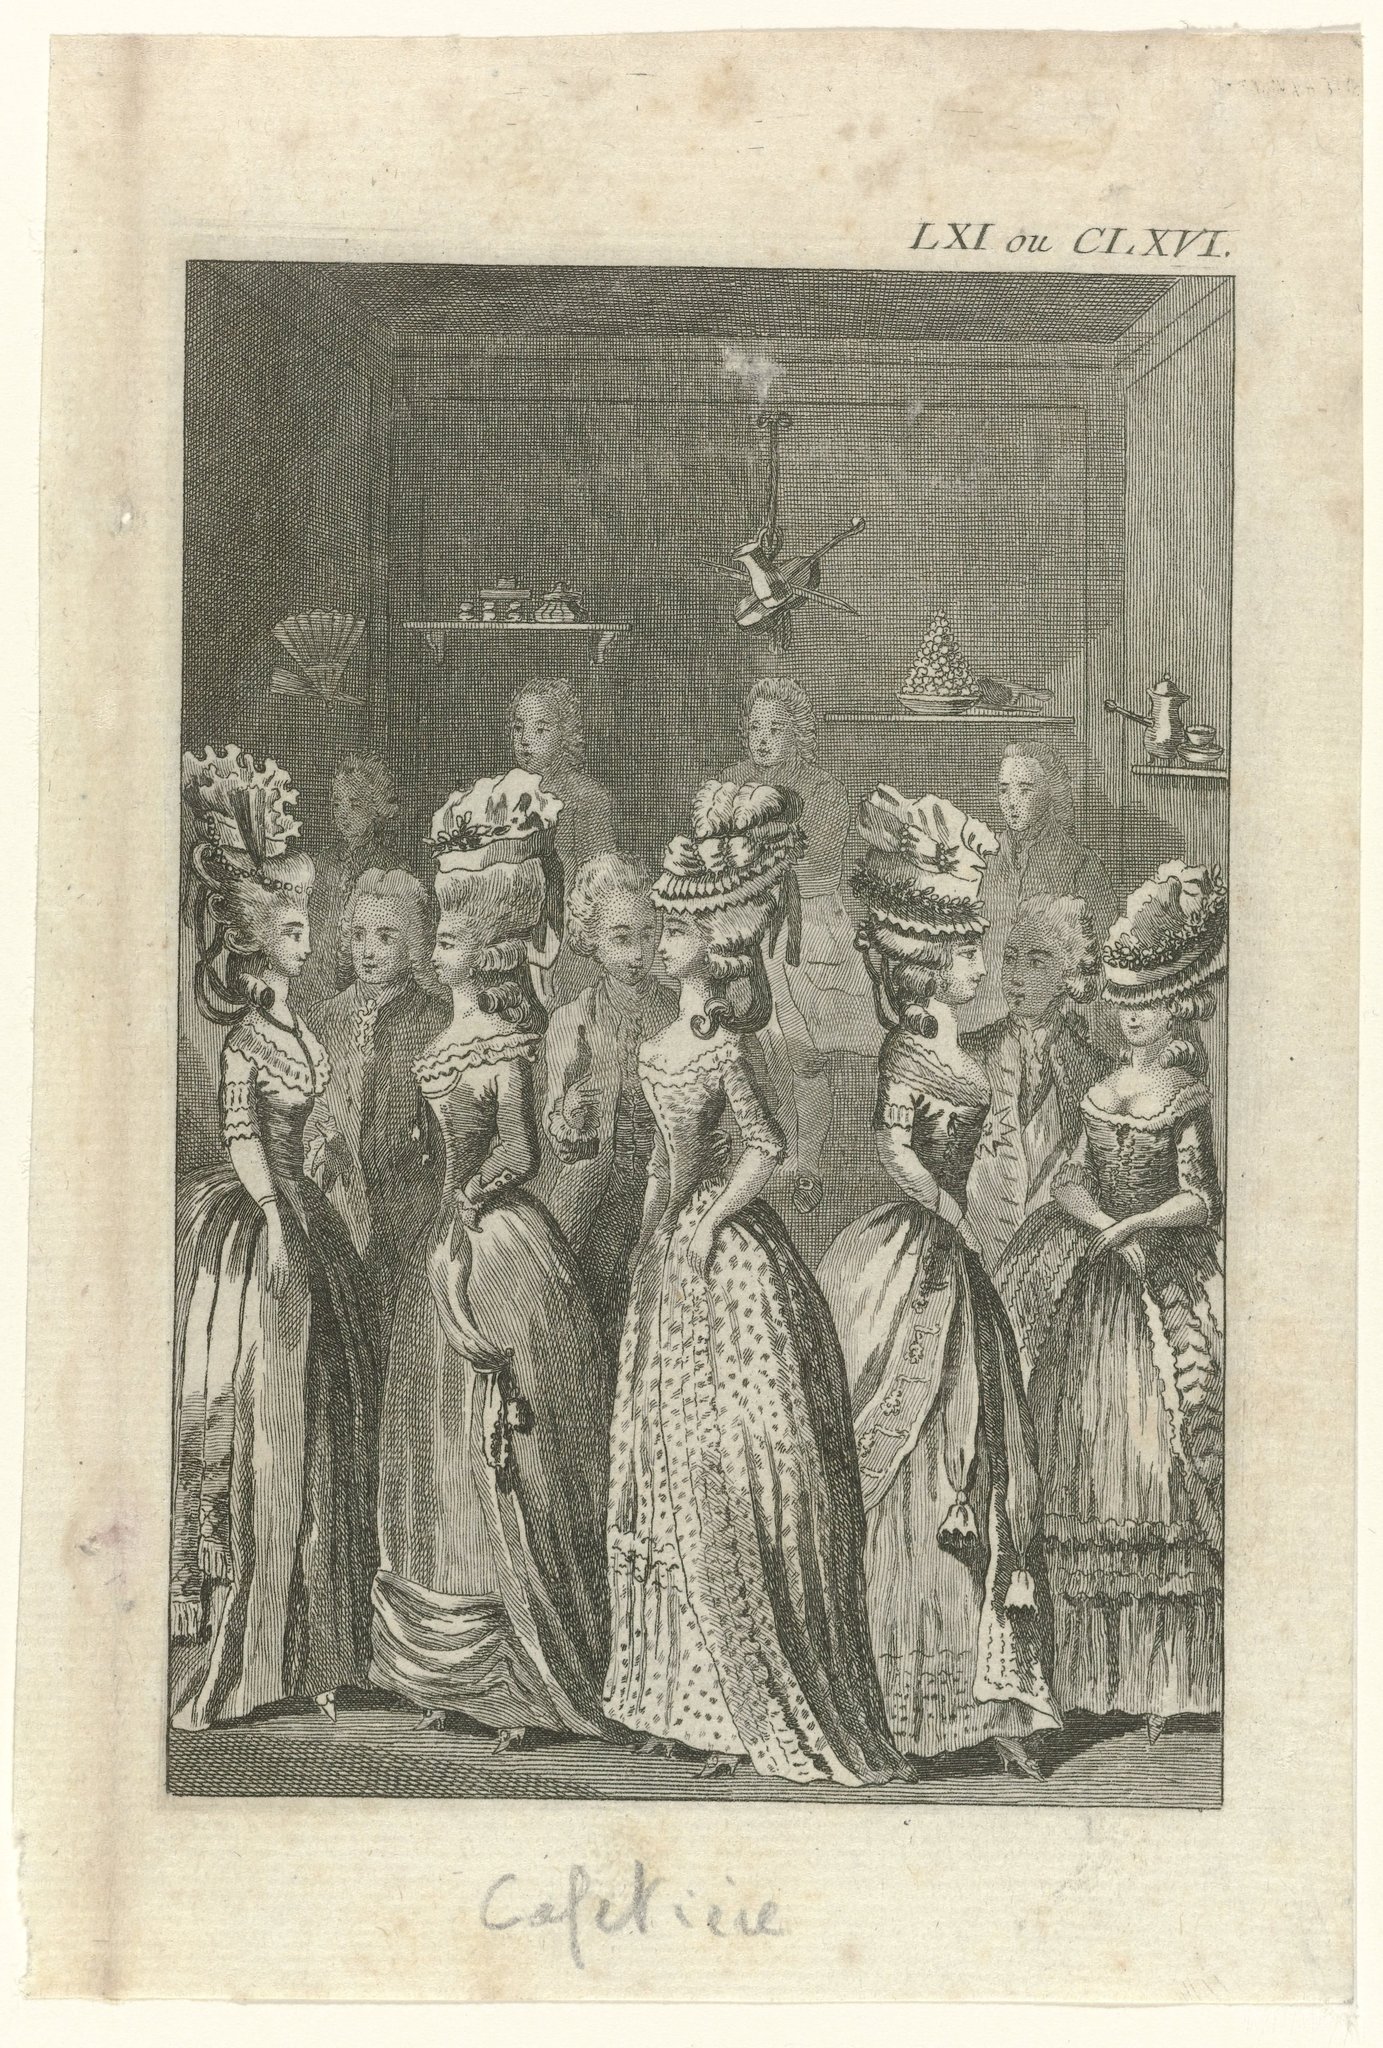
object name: costume print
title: Intererieur van een koffiehuis, ca 1778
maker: Anonymous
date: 1778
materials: paper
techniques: etching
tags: wig - aa - ~ women, inn, coffee-house, public house, etc., head-gear: cap (+ women's clothes), fashion plates, dress, gown (+ women's clothes), clothing for the upper part of the body (+ men's clothes)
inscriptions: inscription: ‘LXI ou CLXVI.’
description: Intererieur van een koffiehuis, ca 1778. Op de voorgrond staan vijf vrouwen, gekleed in verschillende japonnen. Op het hoofd een hoed of muts. Op de achtergrond zeven mannen. Enkele plankjes aan de muren.